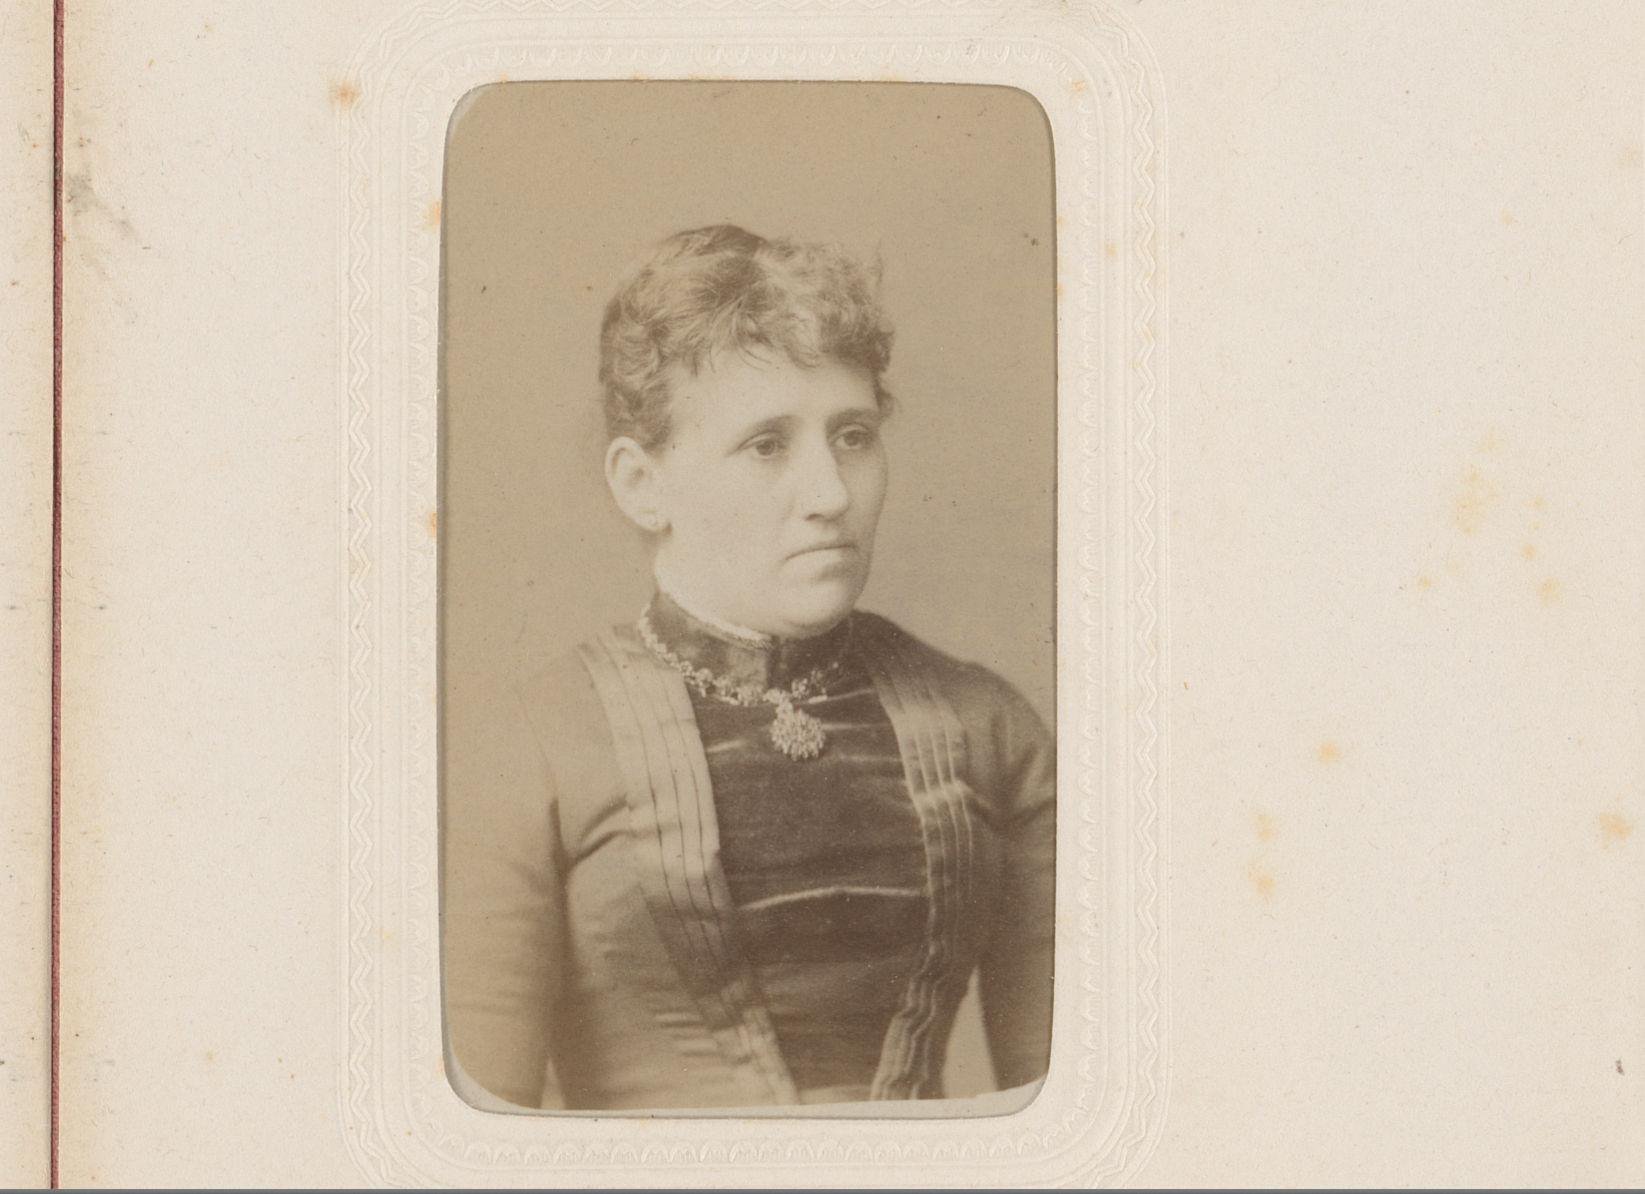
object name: carte de visite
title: Studioportret van een vrouw gekleed in een nauwsluitend bovenstuk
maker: albert greiner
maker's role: fotograaf, fotostudio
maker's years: 1833-1890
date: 1863-1866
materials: cardboard, paper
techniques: albumen print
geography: amsterdam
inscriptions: name: ‘Albert Greiner Amsterdam’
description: De vrouw draagt een collier rond haar nek.